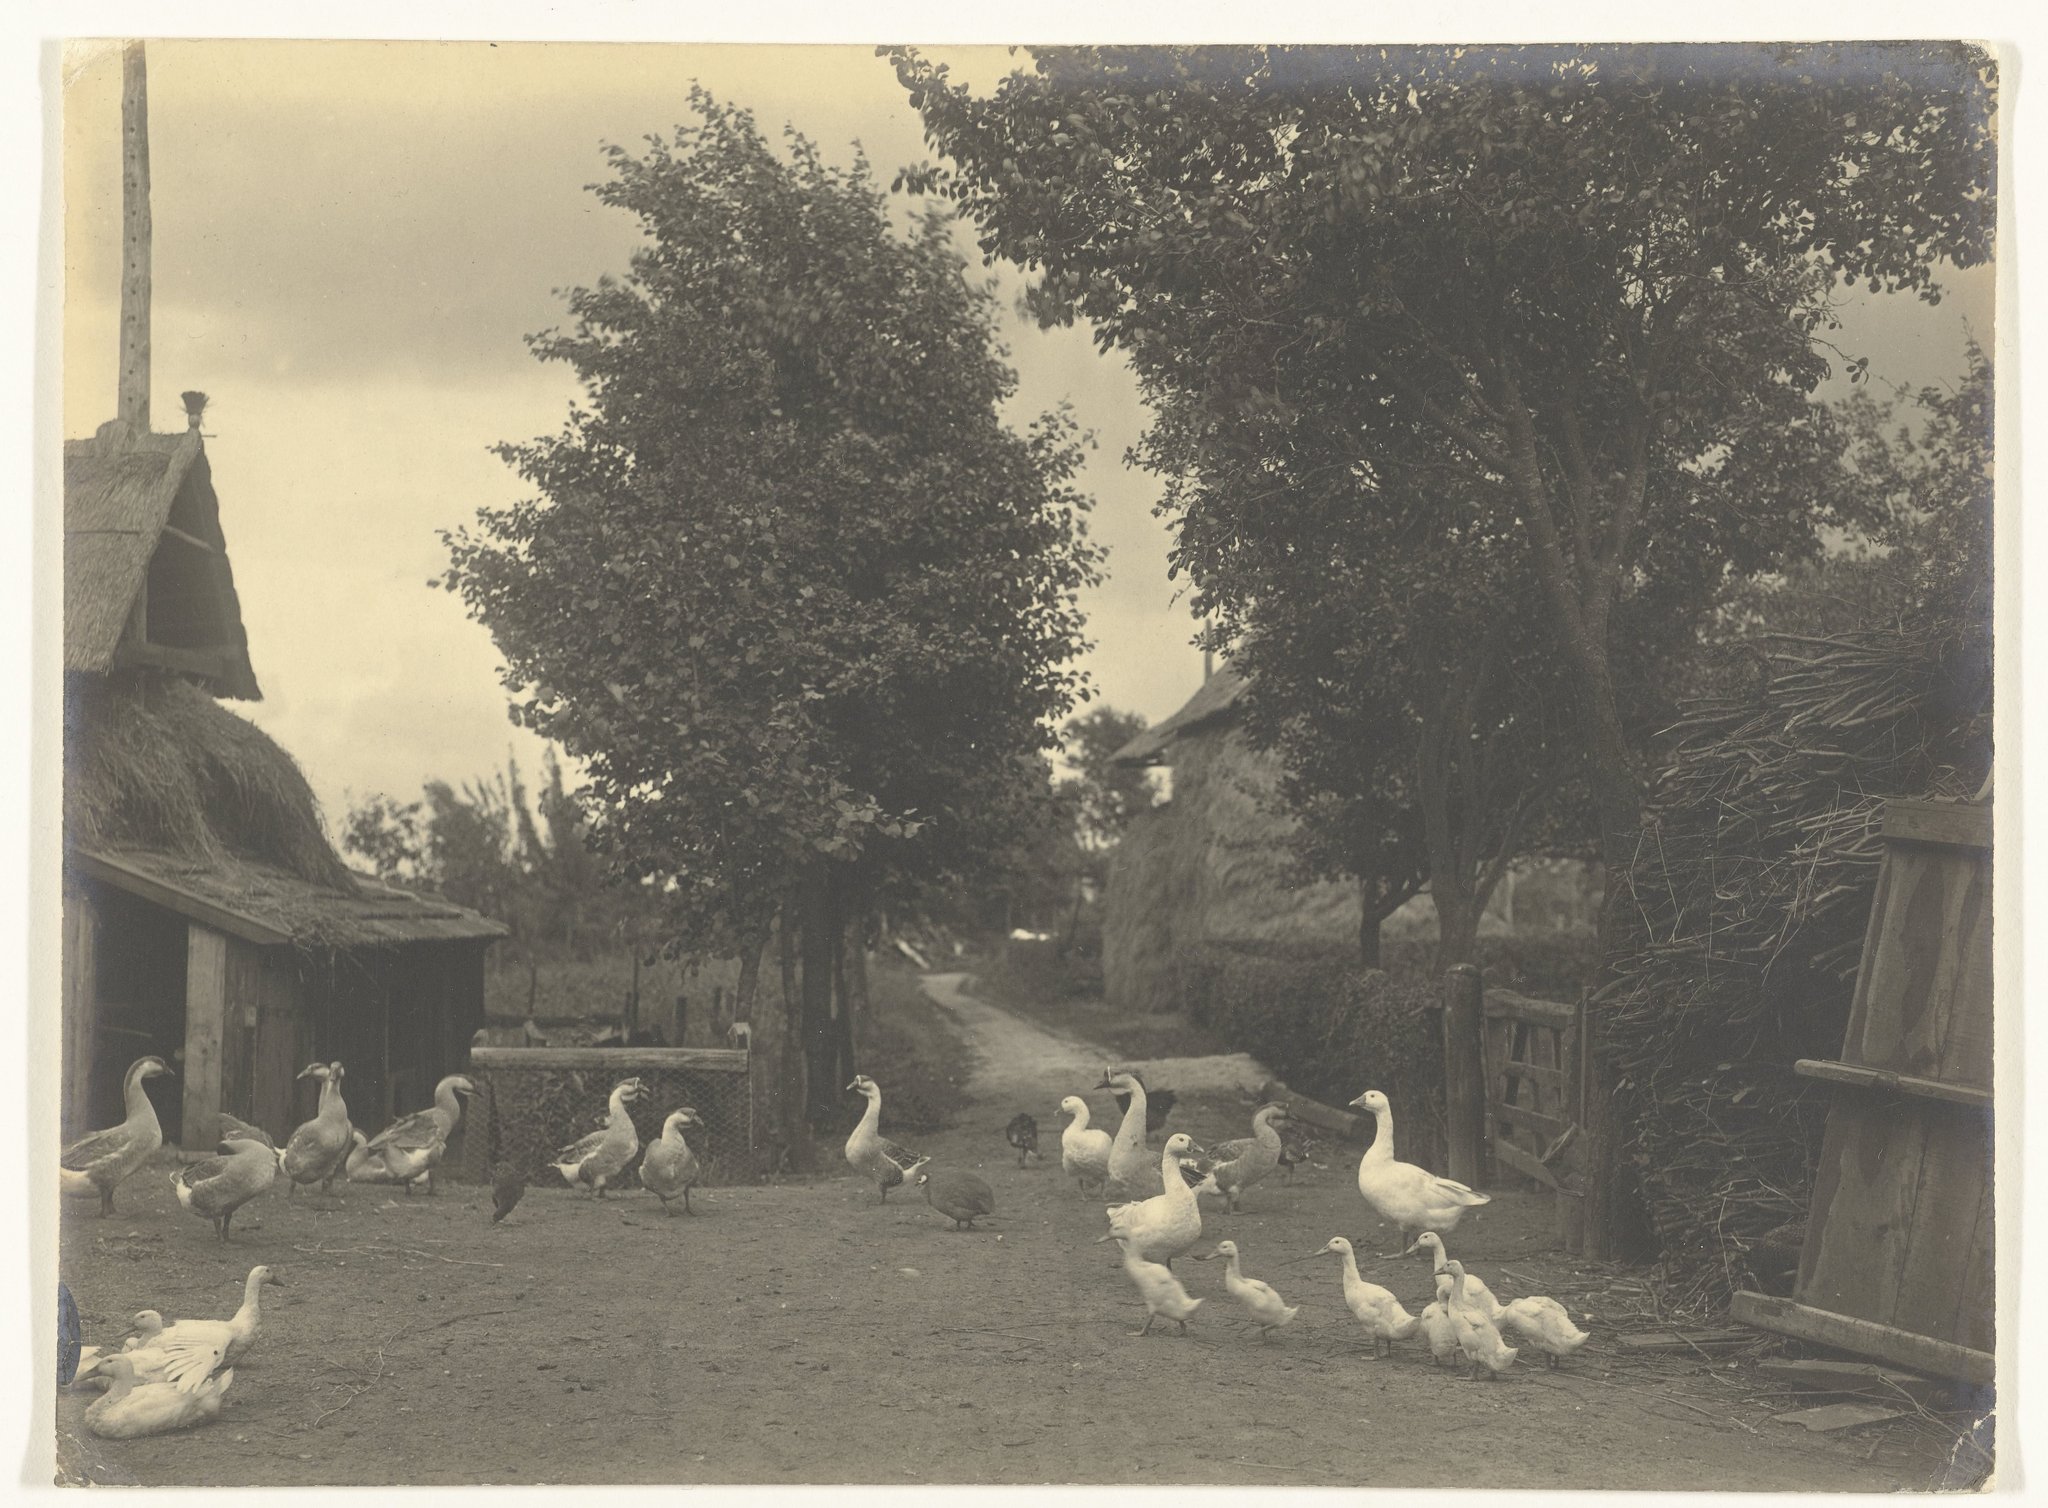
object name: photograph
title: Erf met pluimvee van een boerderij in Vaassen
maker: richard tepe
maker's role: fotograaf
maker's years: 1864-1952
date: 1900-1930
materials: paper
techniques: gelatin silver print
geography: netherlands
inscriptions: signature: ‘foto / R. Tepe’, annotation: ‘Guinea of Knobbelganzen / Witte Ganzen, Witte Loopeenden / en ander pluimvee / op eene boerderij te Vaassen / Guinea oder Höcker [?] Gänse, Weisse Gänse / Weisse Indische Laufenten und anderes Federvieh / auf einen Bauernhof zu Vaassen / Holland’